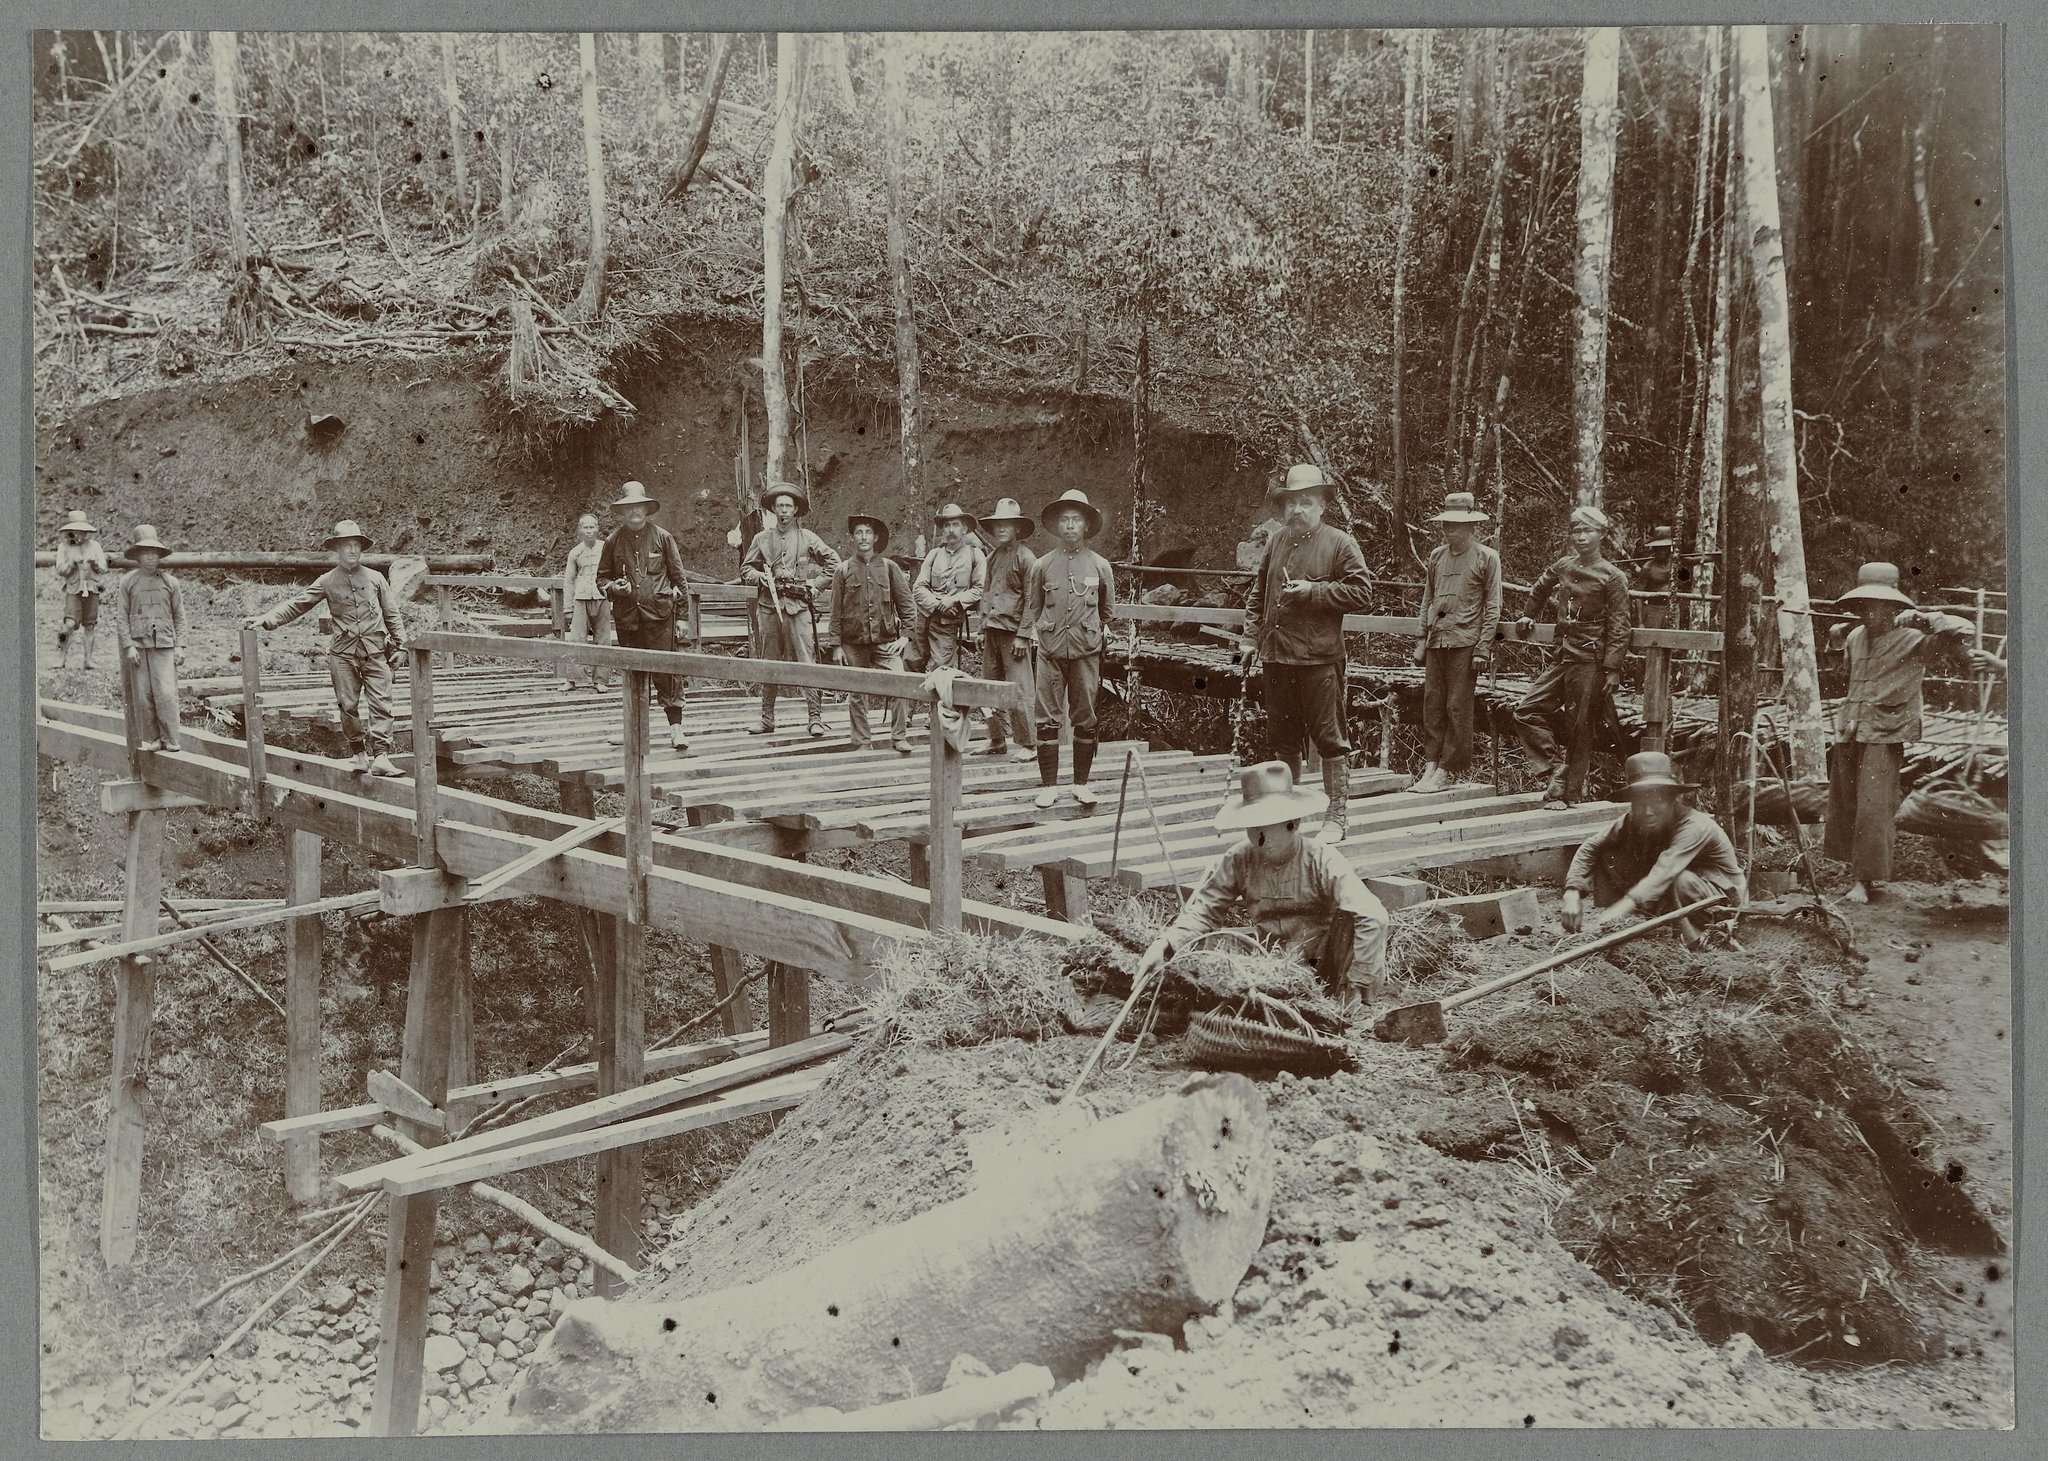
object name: photograph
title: Bouw van een houten brug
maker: Anonymous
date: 1903-1913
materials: photographic support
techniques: photography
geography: north sumatra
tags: arnhem, the hague, albertus dominicus laman trip, building activities, military service, traffic by road or path with motor-vehicle, landscapes in tropical and sub-tropical regions, road, path, bridge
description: Na de expedities naar de Gajo- en Alaslanden o.l.v. Van Daalen (eerste tocht in 1901), werd hij in 1903 belast met voorbereiding van permanente vestiging van Nederlands gezag. Aanleg van een weg van de Noordkust naar het binnenland was hierbij van groot belang. Deze zgn. Gajoweg werd aangelegd tussen 1903 en 1914, van Bireuen aan de kust naar Takinguen aan het bergmeer Danau Lauttawar, totale lente 104 km.